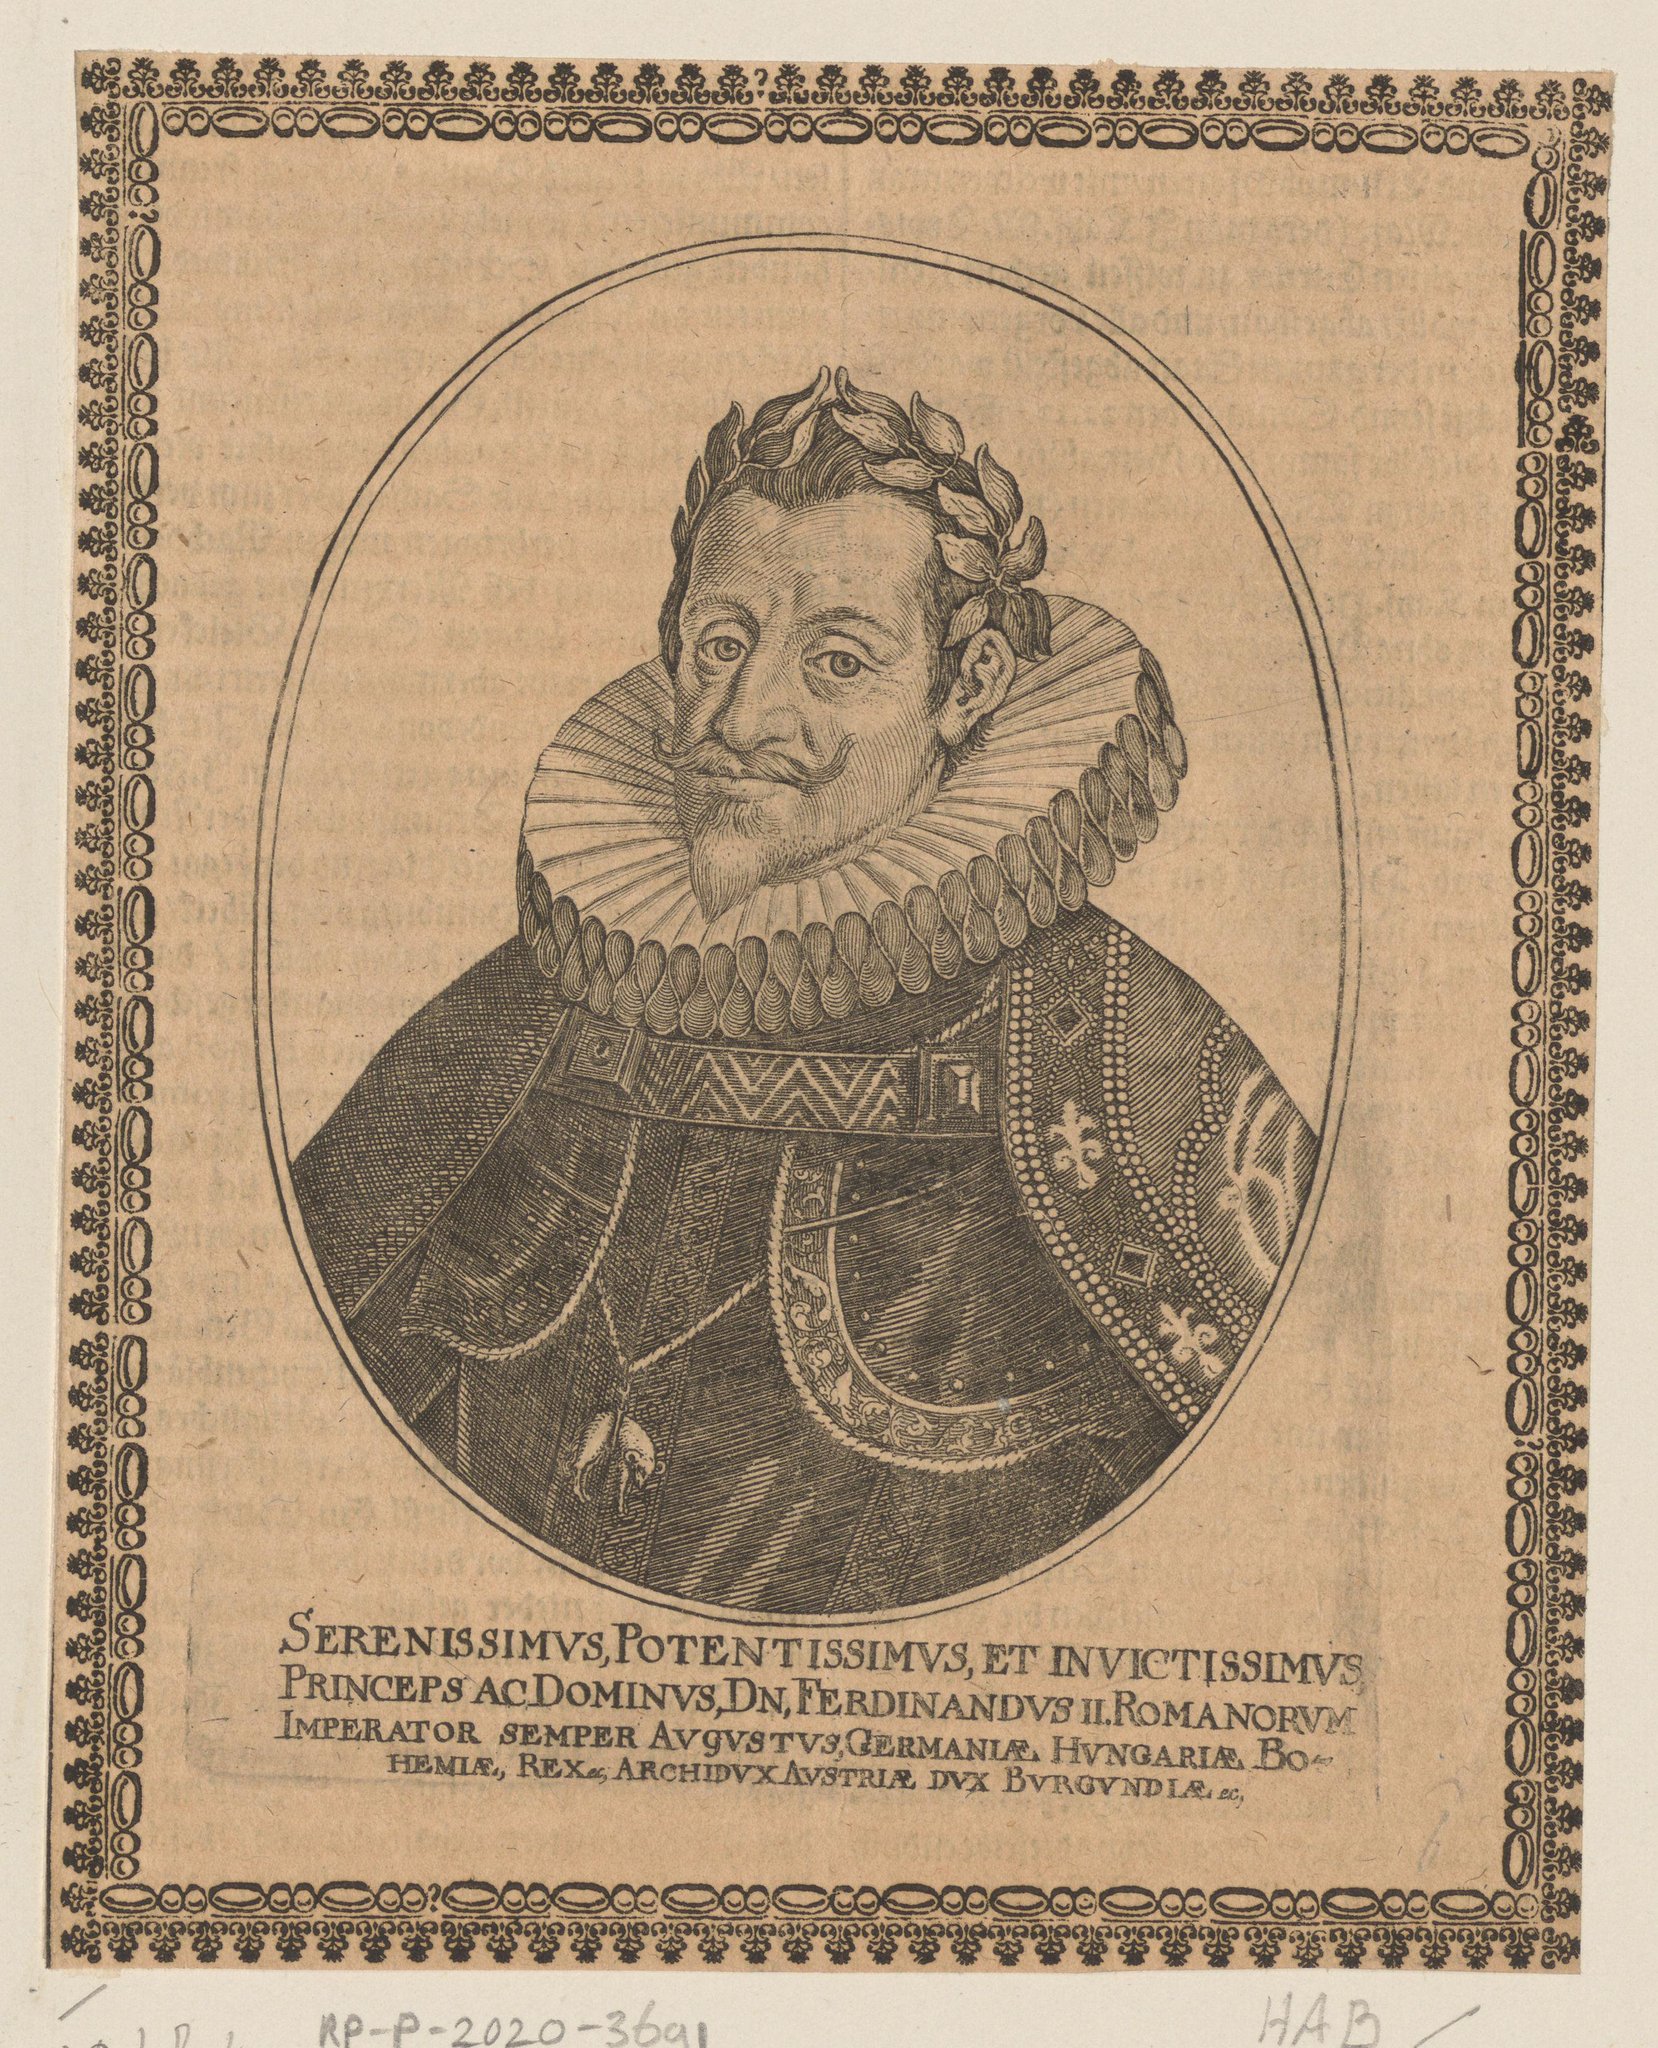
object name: print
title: Portret van keizer Ferdinand II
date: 1670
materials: paper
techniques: engraving, etching, letterpress printing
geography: frankfurt am main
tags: vienna, ferdinand ii (duits keizer), historical persons, knighthood order of the golden fleece, emperor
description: Prent uit: Theatrum Europaeum (...). Frankfurt am Main: erven Matthäus Merian, 1670, p. 759. Prent eerder gebruikt in eerdere editie van het werk uit 1639.